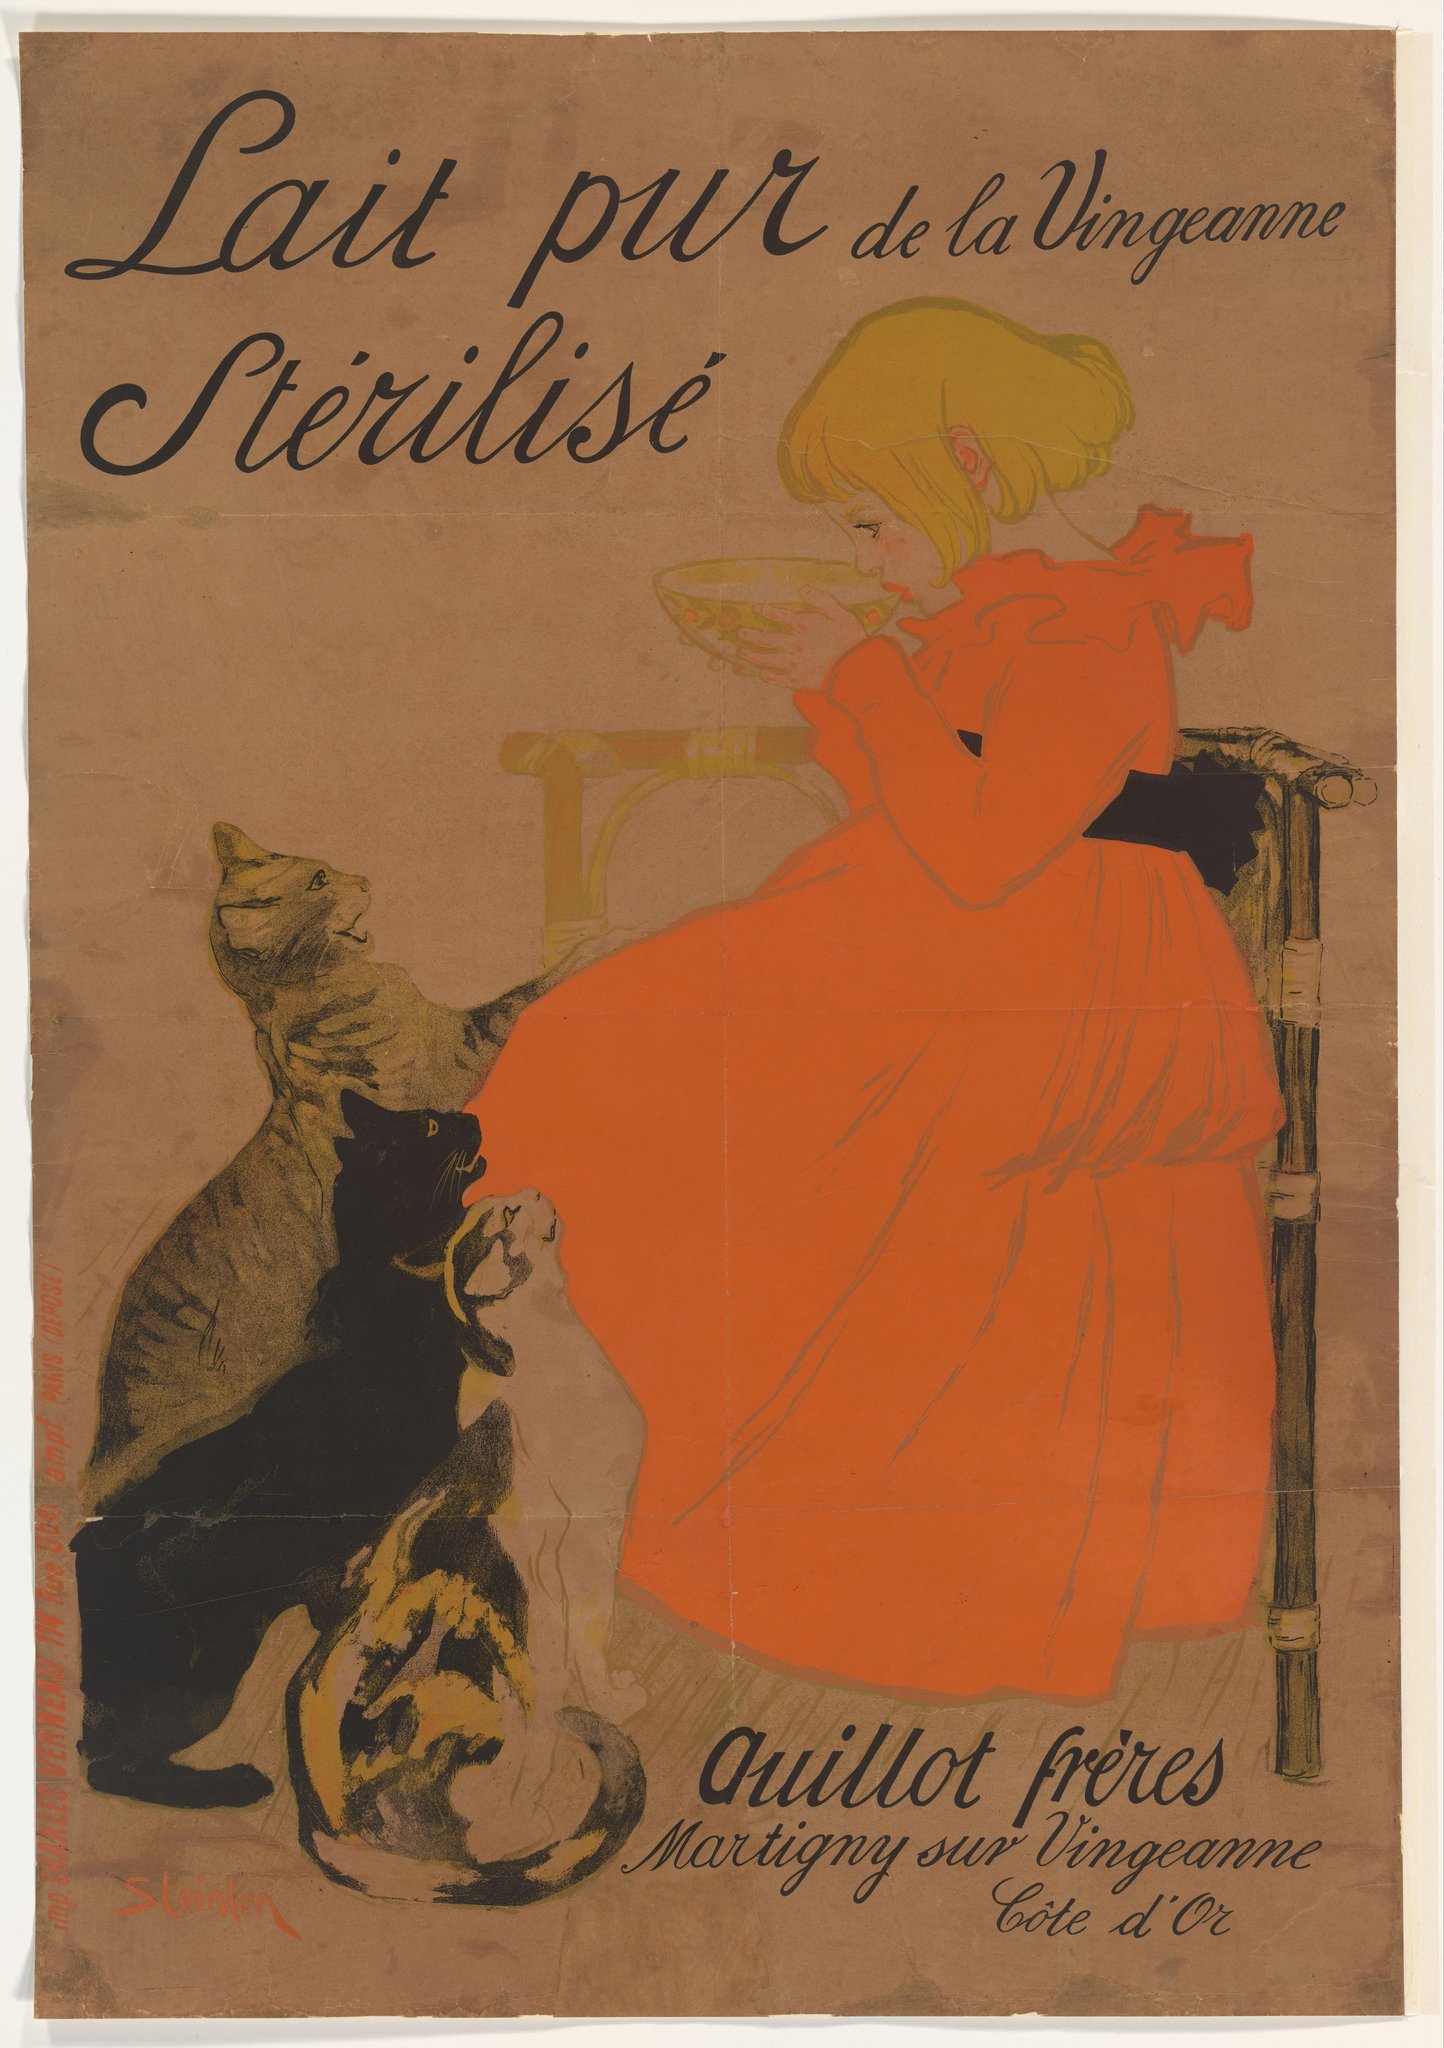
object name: print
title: Lait pur de la Vingeanne Stérilisé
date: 1894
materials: paper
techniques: lithograph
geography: paris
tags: advertising, cat, girl (child between toddler and youth), milk, poster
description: Meisje drink melk uit kom, aan haar voeten kijken drie katten toe.